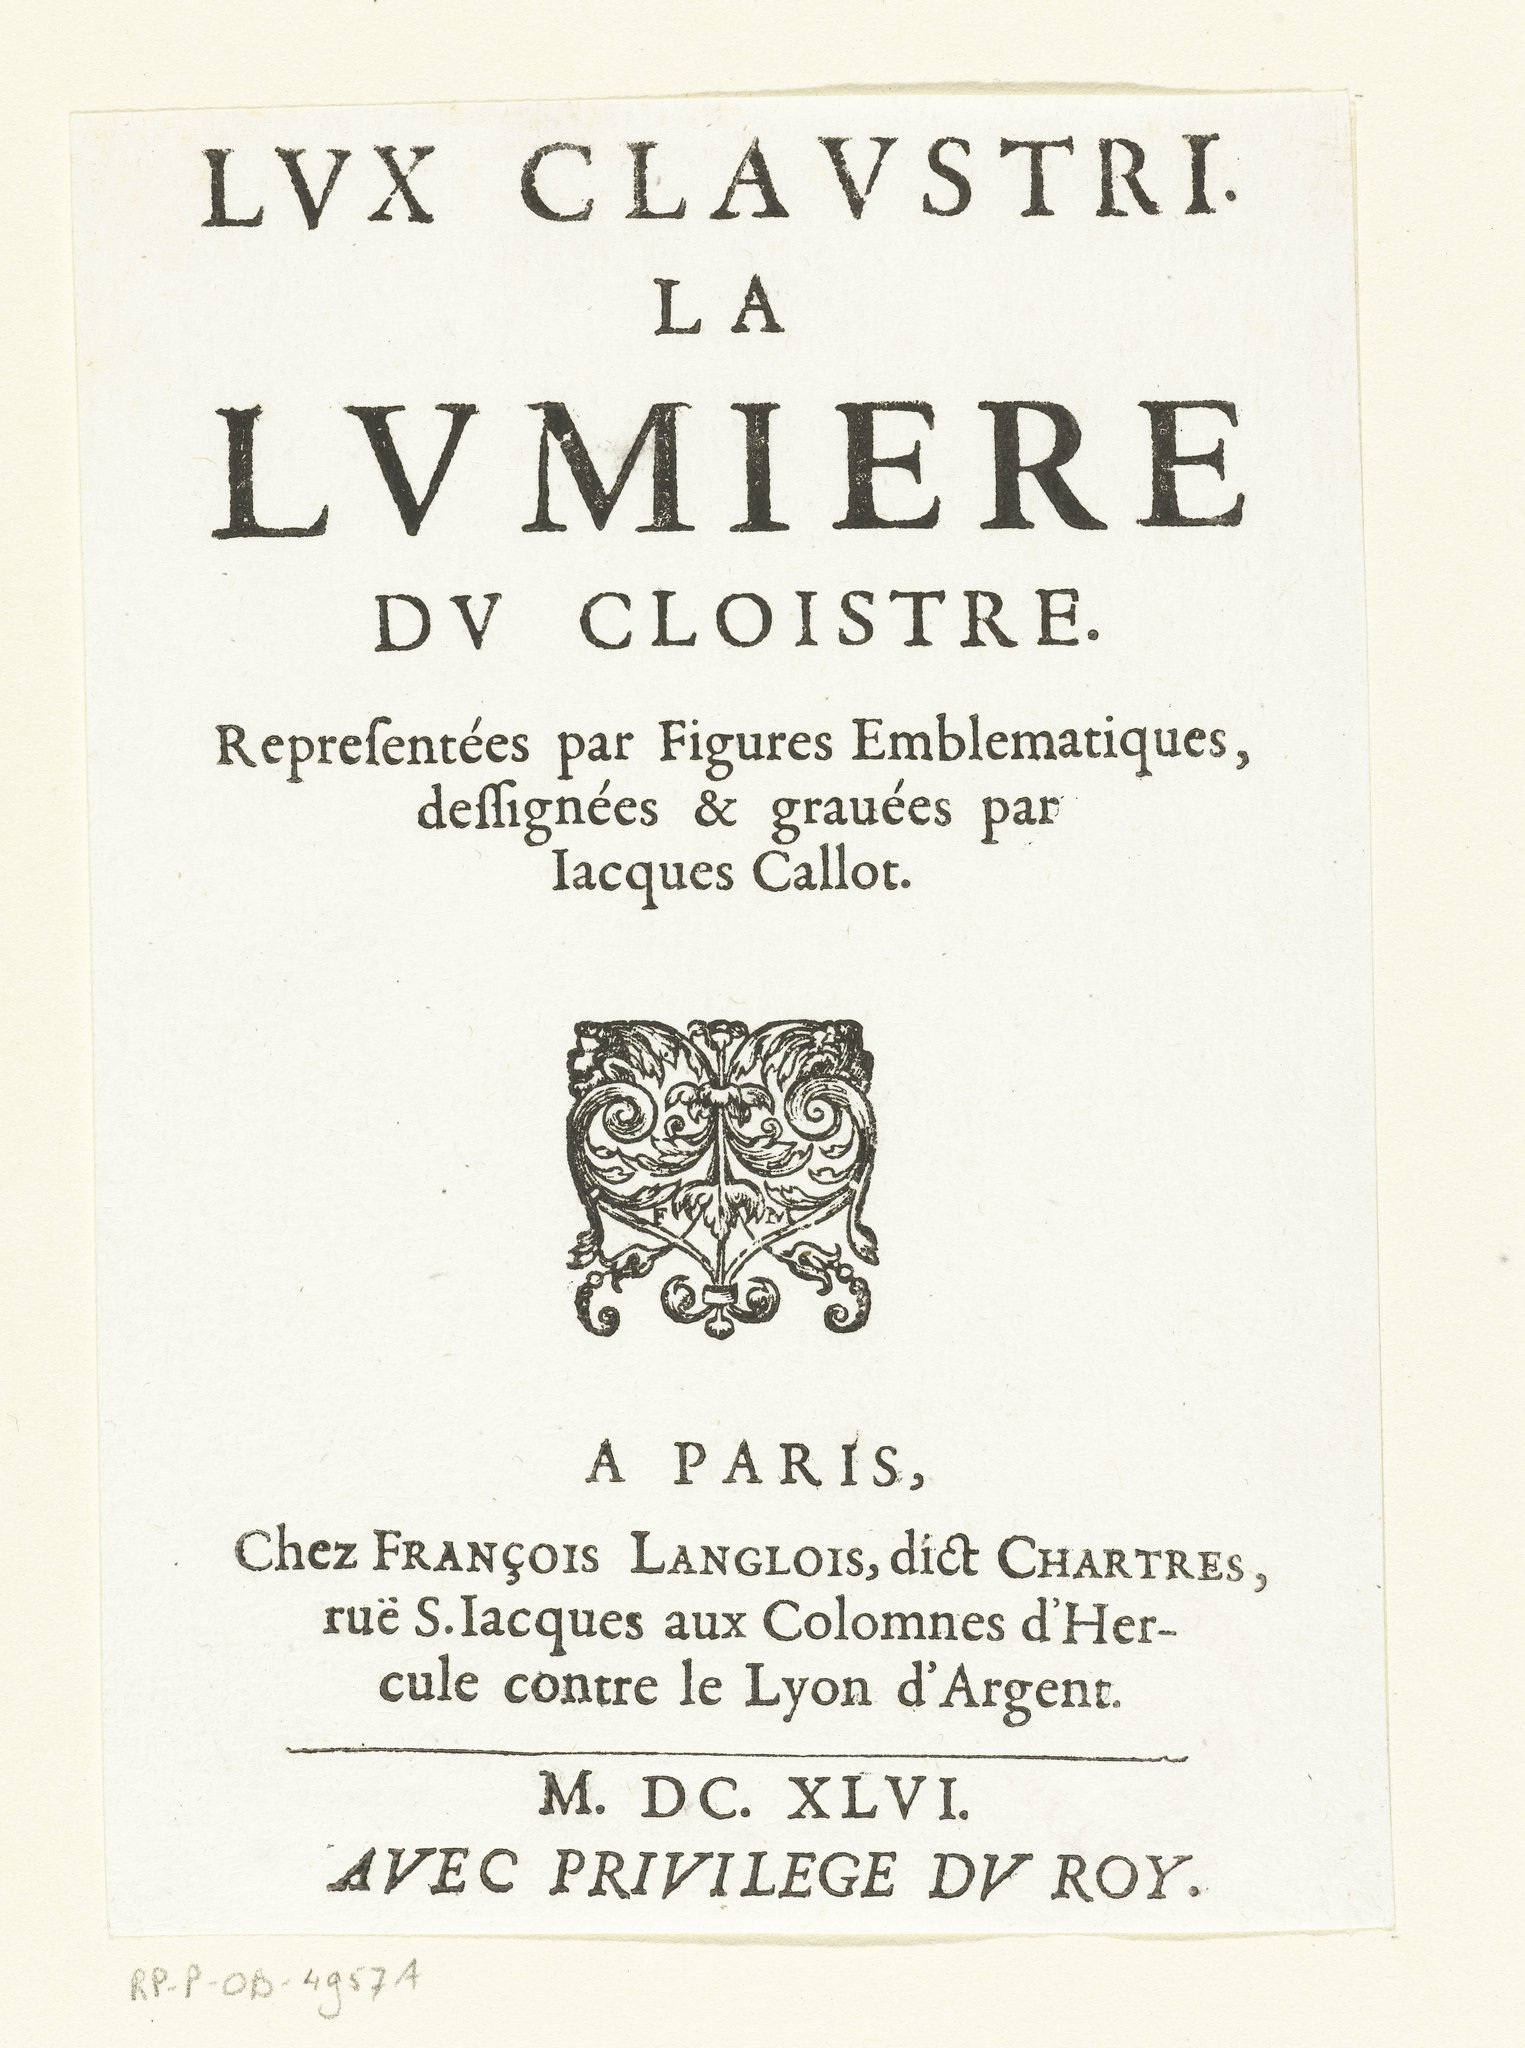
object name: text sheet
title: Lux claustri/La Lumiere du Cloistre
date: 1646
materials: paper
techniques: letterpress printing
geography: paris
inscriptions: collector's mark: Lugt 240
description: Franstalige teksten in boekdruk. Dit blad is de ongeïllustreerde titelpagina voor de tweede staat van de embleemserie 'Kloosterleven in emblemen', die naast deze ongeïllustreerde titelpagina tevens een ongeïllustreerd blad met opdracht, een geïllustreerde titelpagina en 26 emblemen behelst.